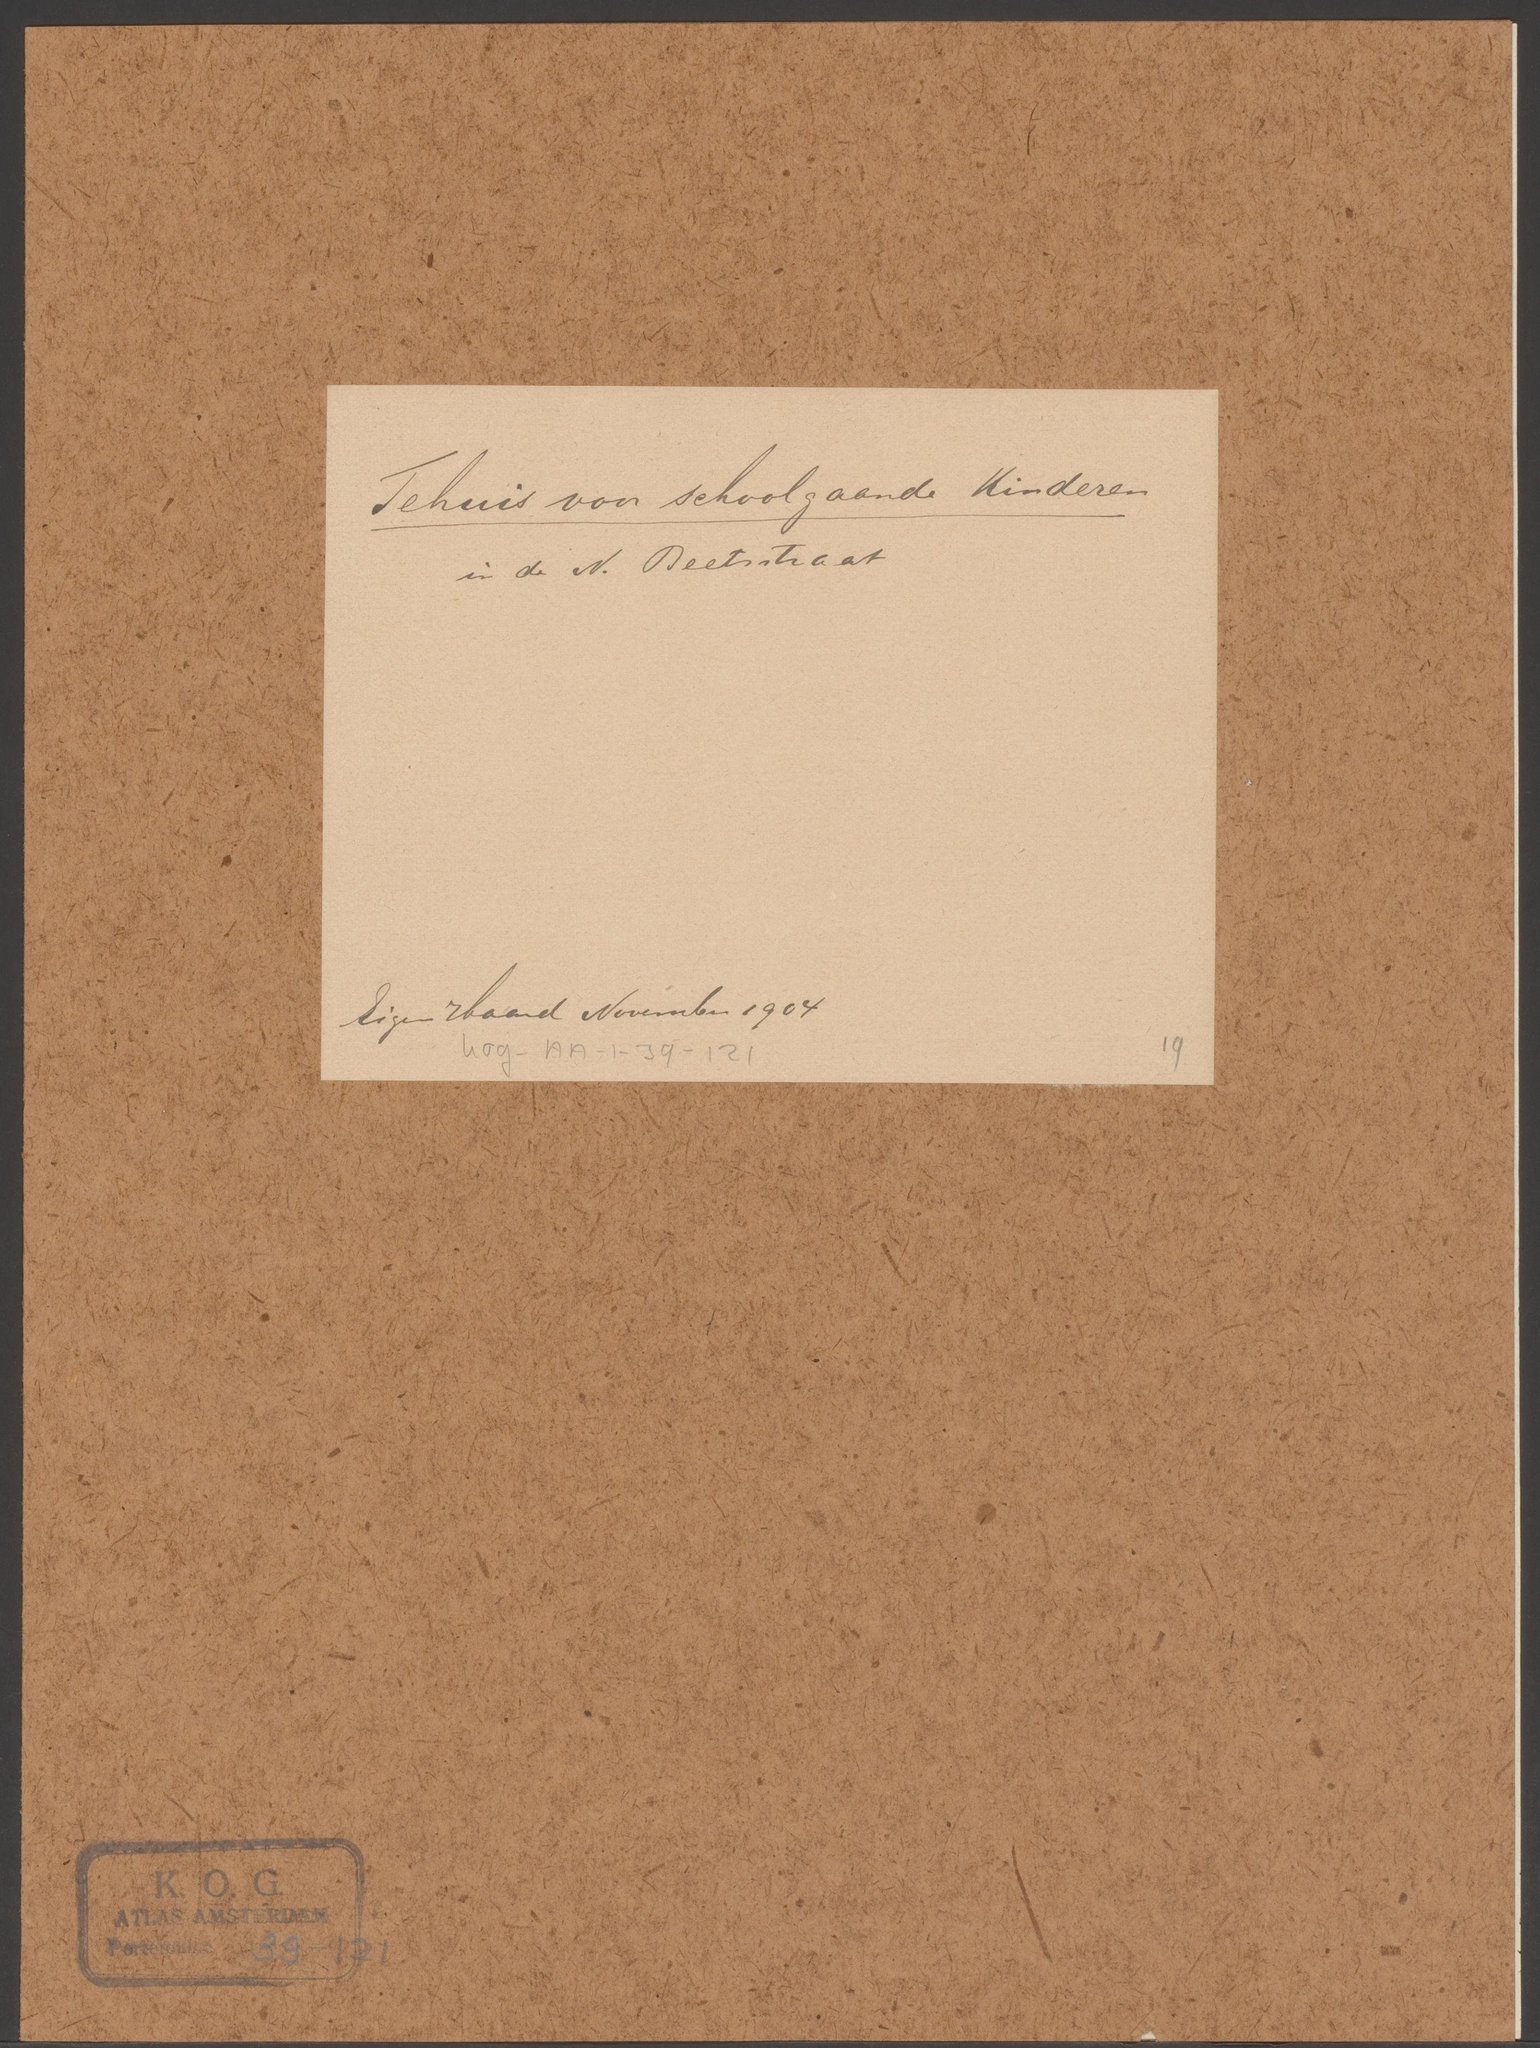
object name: article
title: Tehuizen voor schoolgaande kinderen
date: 1904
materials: paper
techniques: letterpress printing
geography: netherlands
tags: child, communal rooms, playground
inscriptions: collector's mark: Lugt 1641b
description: Object bestaat uit twee aan elkaar geplakte bladen in een bruine omslag. Drie fotomechanische afdrukken op pagina 761. Onderwerpsrubriek binnen de Atlas Amsterdam: Armwezen en liefdadige instellingen: III. Verschillende gestichten en instellingen / Hofjes: Vrouwen-logement ‘Te Huis' - Boddaert Tehuizen - Tehuis “Koningin Wilhelmina” - Zuigelingen-inrichting.